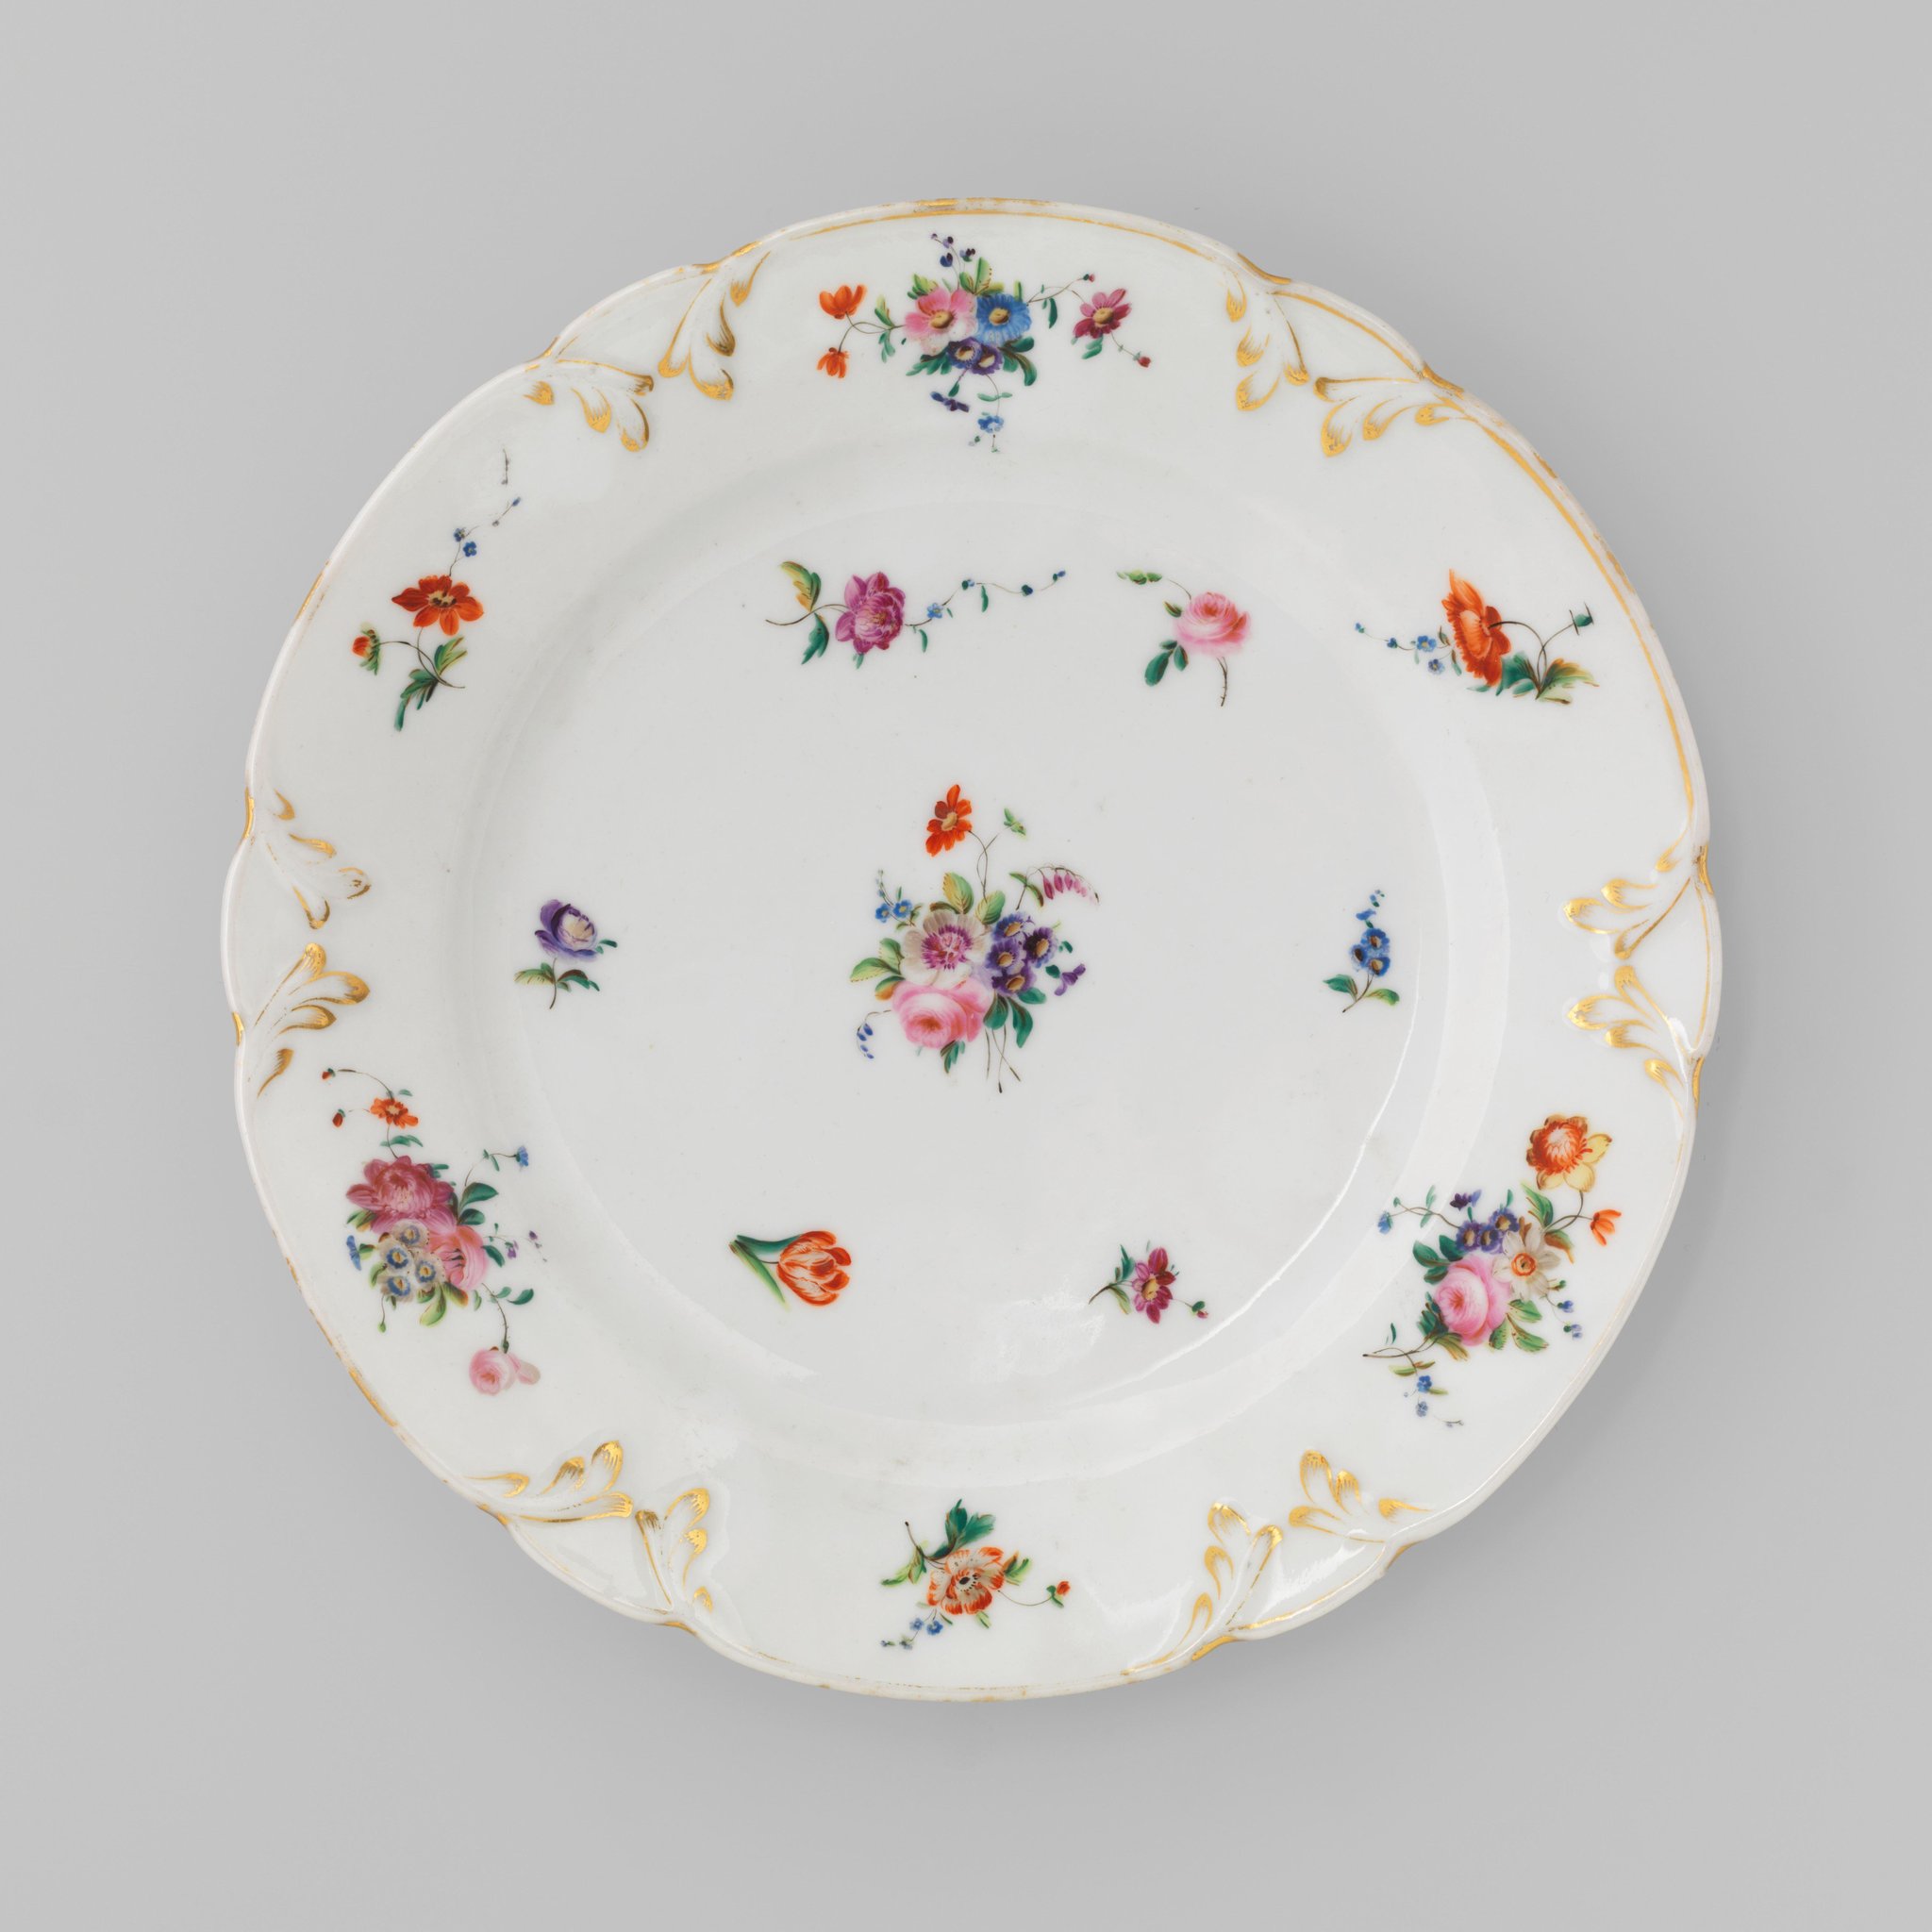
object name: service set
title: Plate with bouquets and flower sprays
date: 1839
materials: glaze, gold, paint, porcelain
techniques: firing, forming, gilding, turning, vitrification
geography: paris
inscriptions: mark: ‘DENUELLE/ Boulevard St. Denis 18/ à Paris’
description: Bord van porselein met een gelobde rand, beschilderd op het glazuur in blauw, rood, roze, groen, geel, paars, zwart en goud. Op het plat boeketten van verschillende bloemen en strooibloemen. Vanuit de gelobde, gouden rand, gemodelleerde bladranken in reliëf, aangezet met goud. Hiertussen boeketten. Drie proenen op de onderzijde. Gemerkt op de onderzijde met 'DENUELLE/ Boulevard St. Denis 18/ à Paris'.